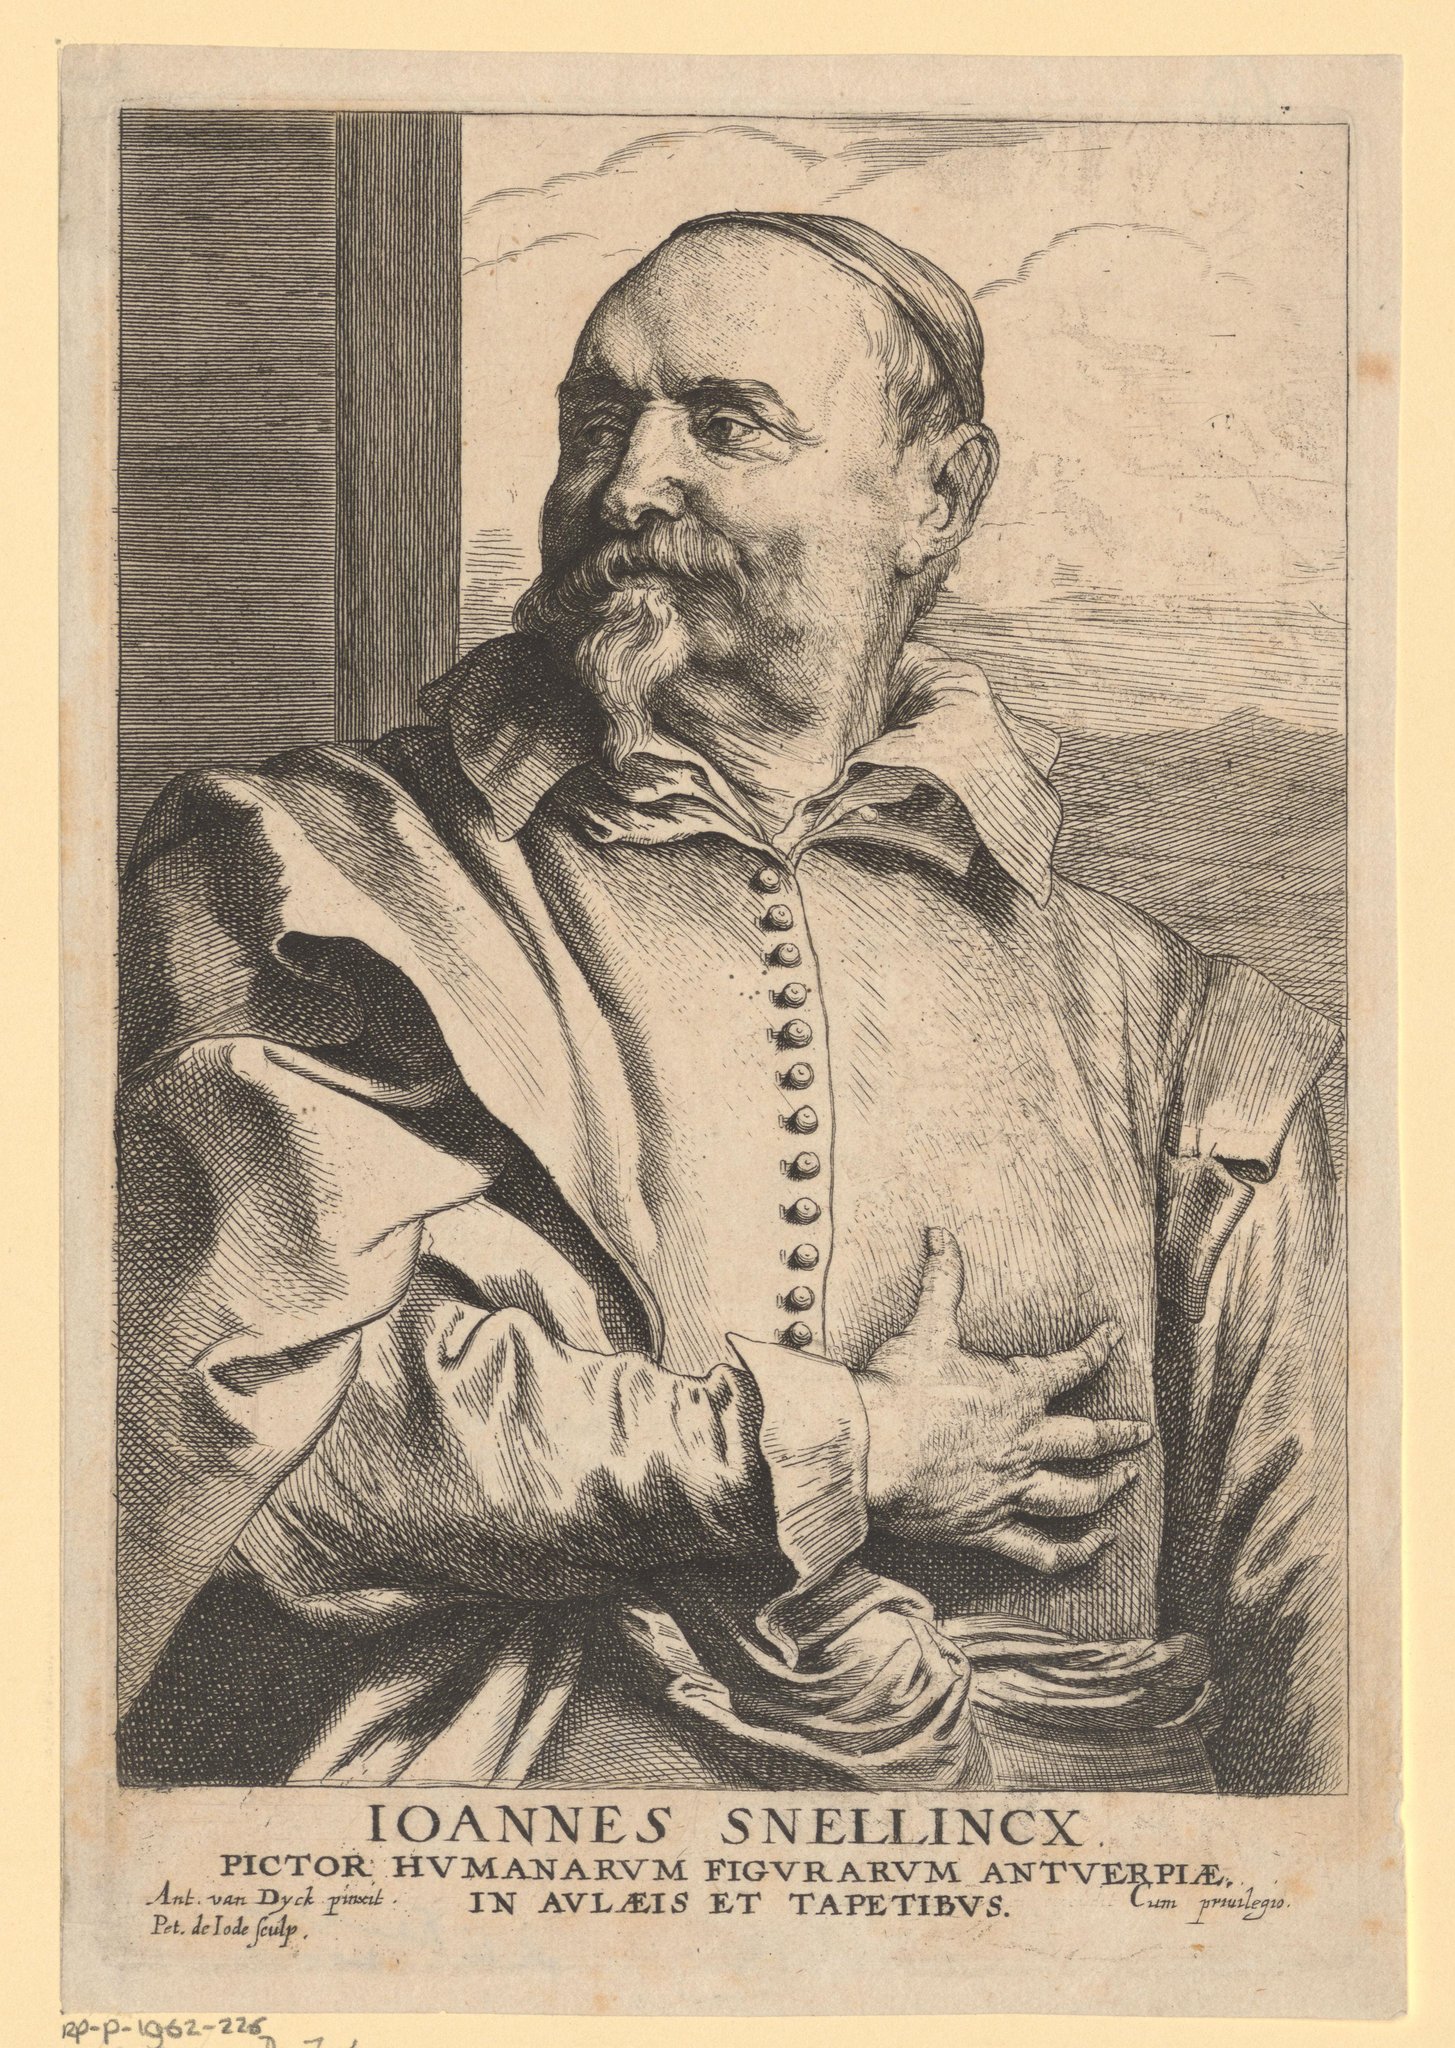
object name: print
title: Portret van Jan Snellinck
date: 1628-1670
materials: paper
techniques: engraving, etching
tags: mechelen, antwerp, draughtsman, jan snellinck (i), historical persons, portrait, self-portrait of artist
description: Met drieregelig onderschrift in het Latijn.